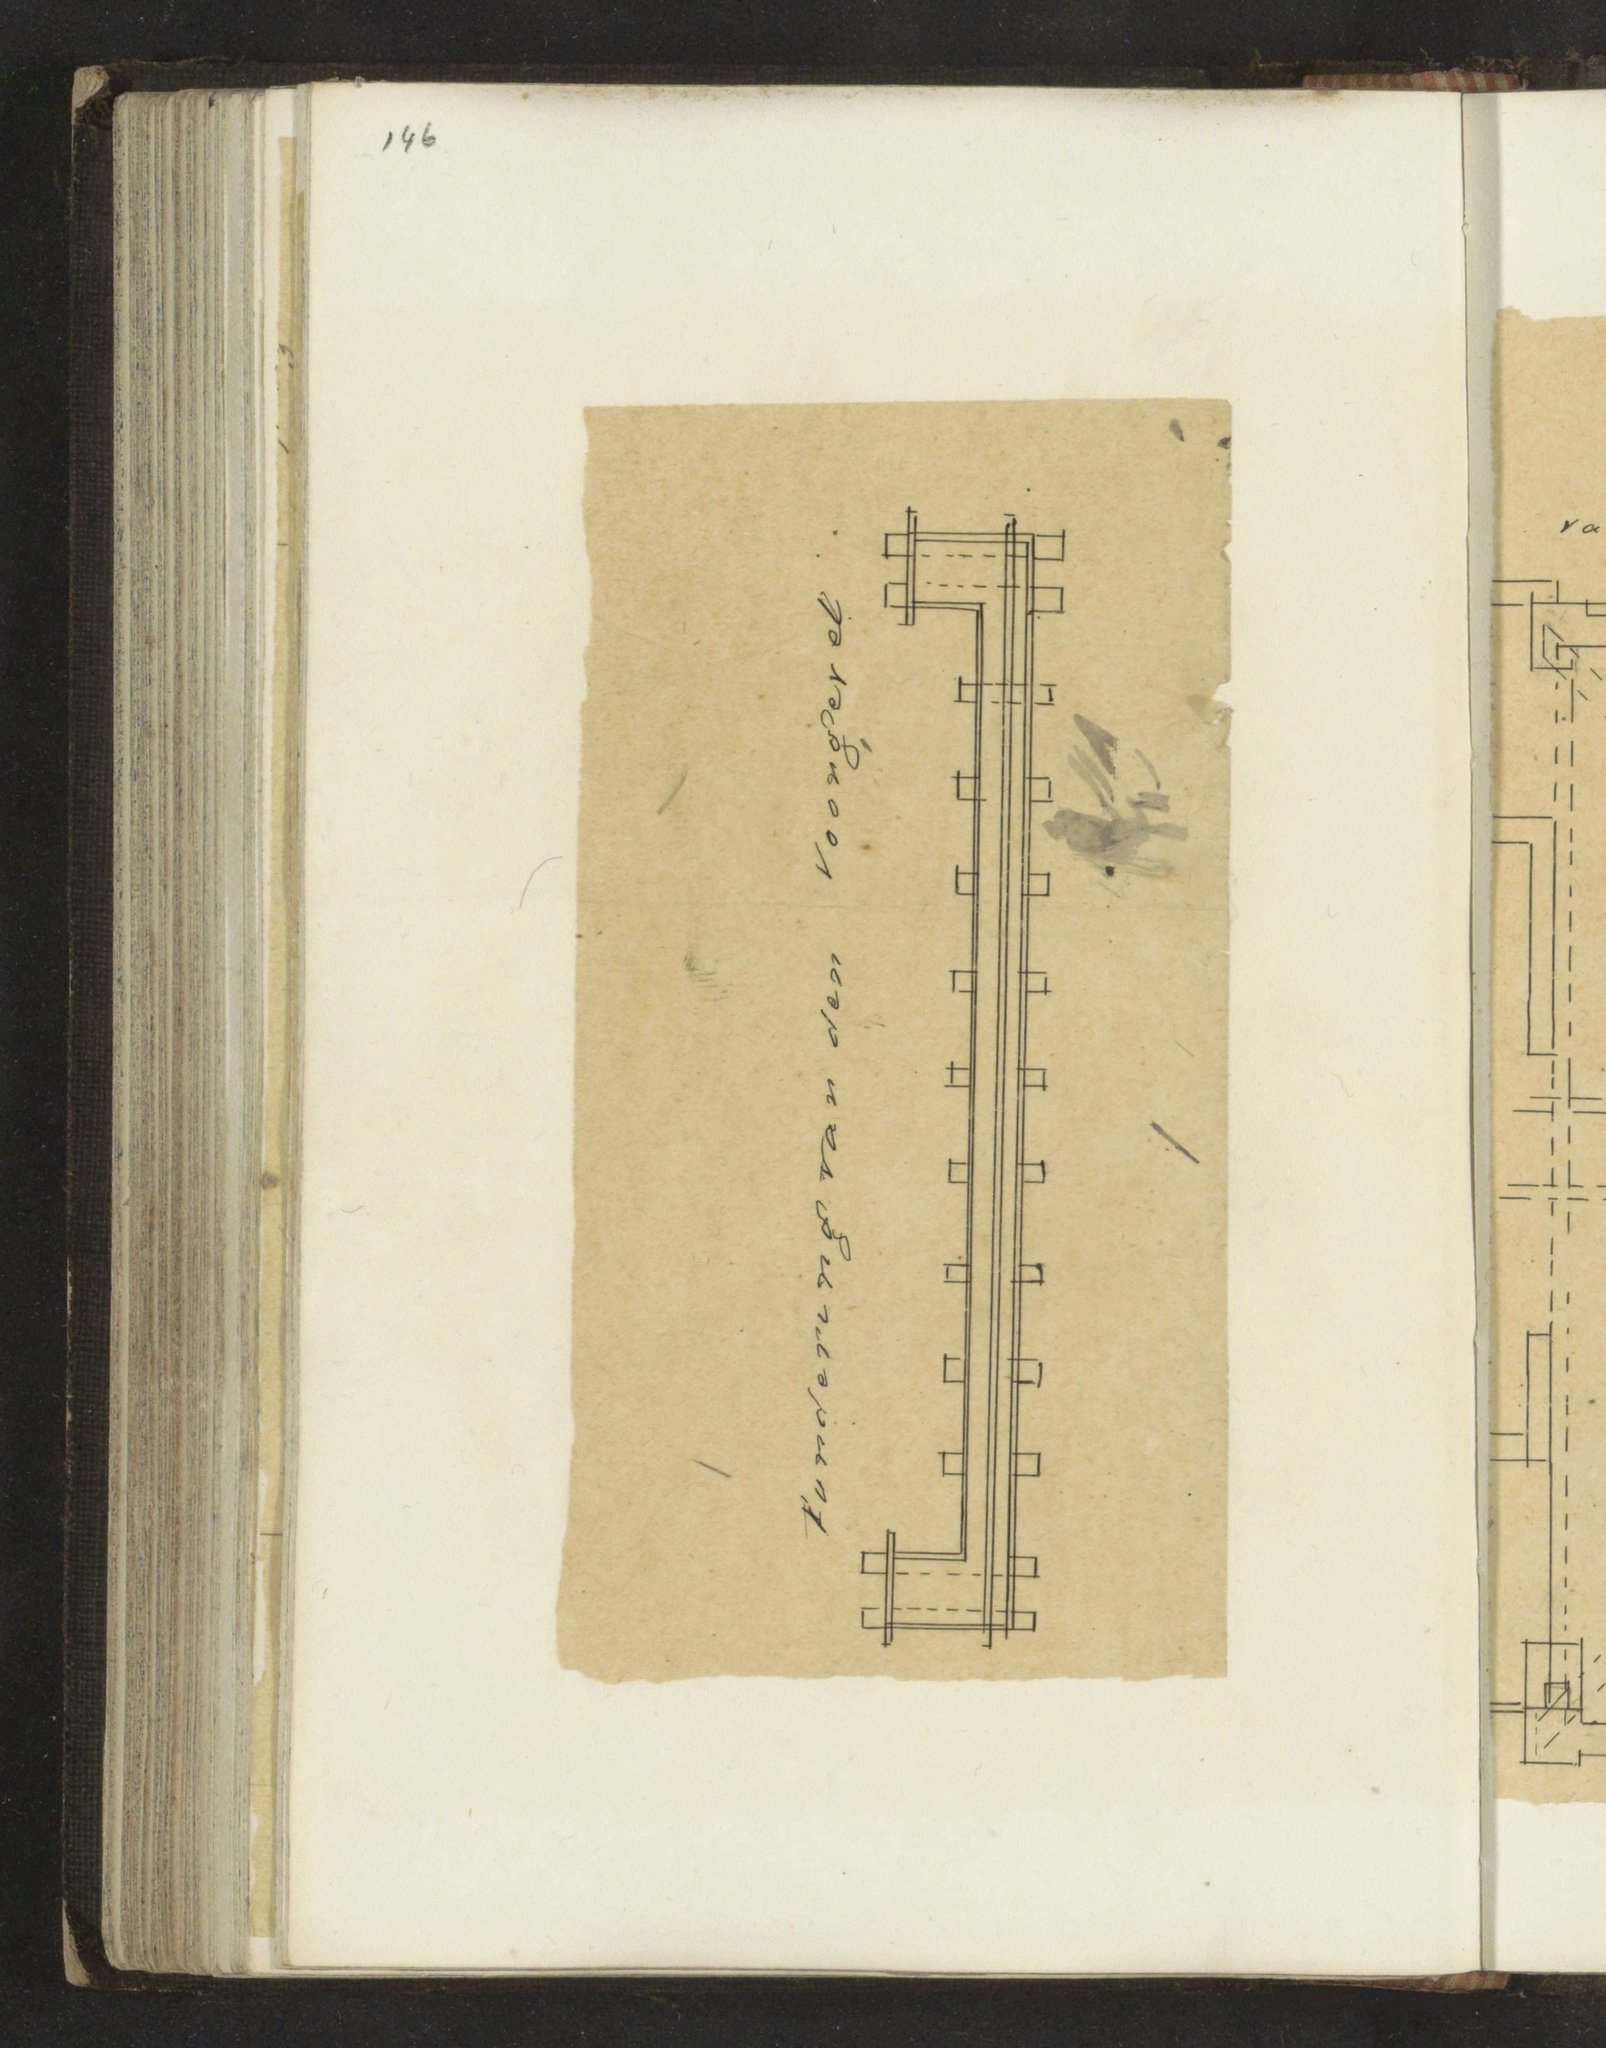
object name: sketchbook leaf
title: Fundering van een voorgevel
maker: willem springer jr.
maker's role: draughtsman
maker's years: 1815-1907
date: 1864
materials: ink, paper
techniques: pen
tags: architecture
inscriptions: annotation: ‘Fundering van den voorgevel’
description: Pagina 146 uit een schetsboek met 164 pagina's.